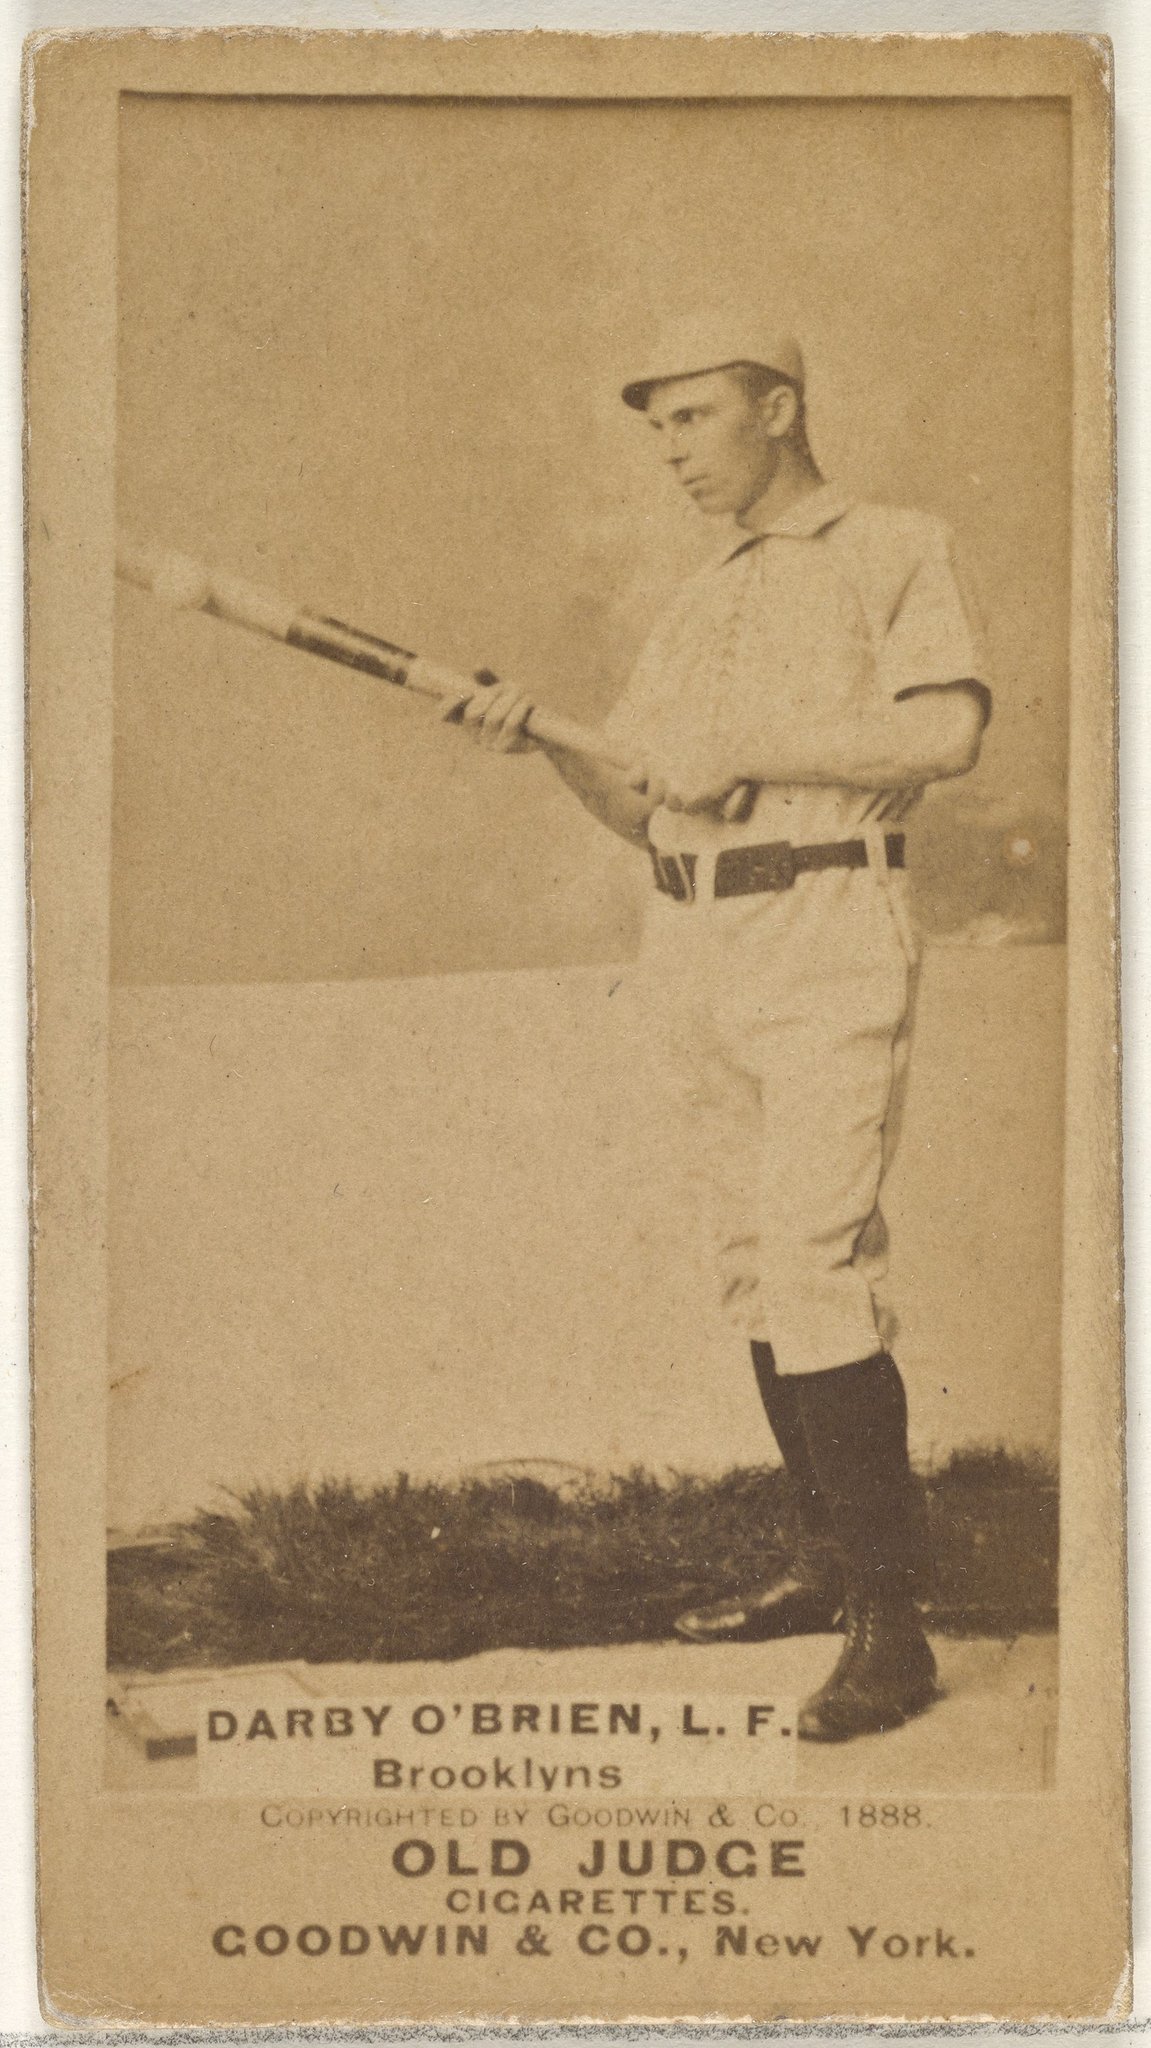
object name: baseball card, photograph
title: Darby O'Brien, Left Field, Brooklyn Bridegrooms, from the Old Judge series (N172) for Old Judge Cigarettes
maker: goodwin & company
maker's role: publisher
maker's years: 1850-1950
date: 1888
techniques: albumen silver print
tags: men,portraits,baseball,athletes